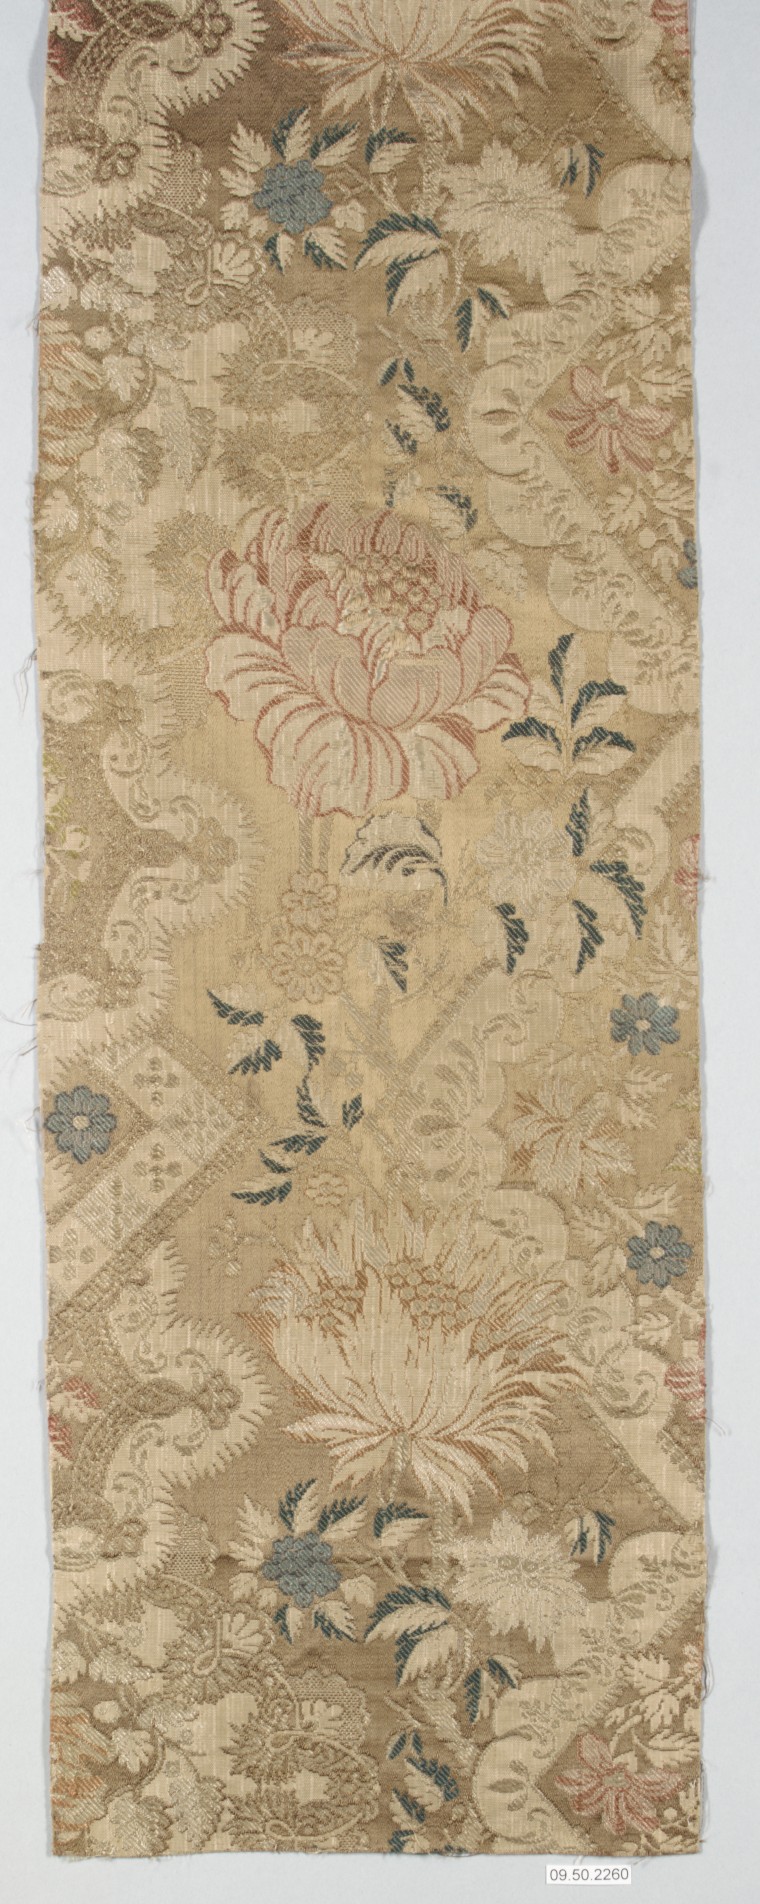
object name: piece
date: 1725-1730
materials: silk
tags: flowers,leaves